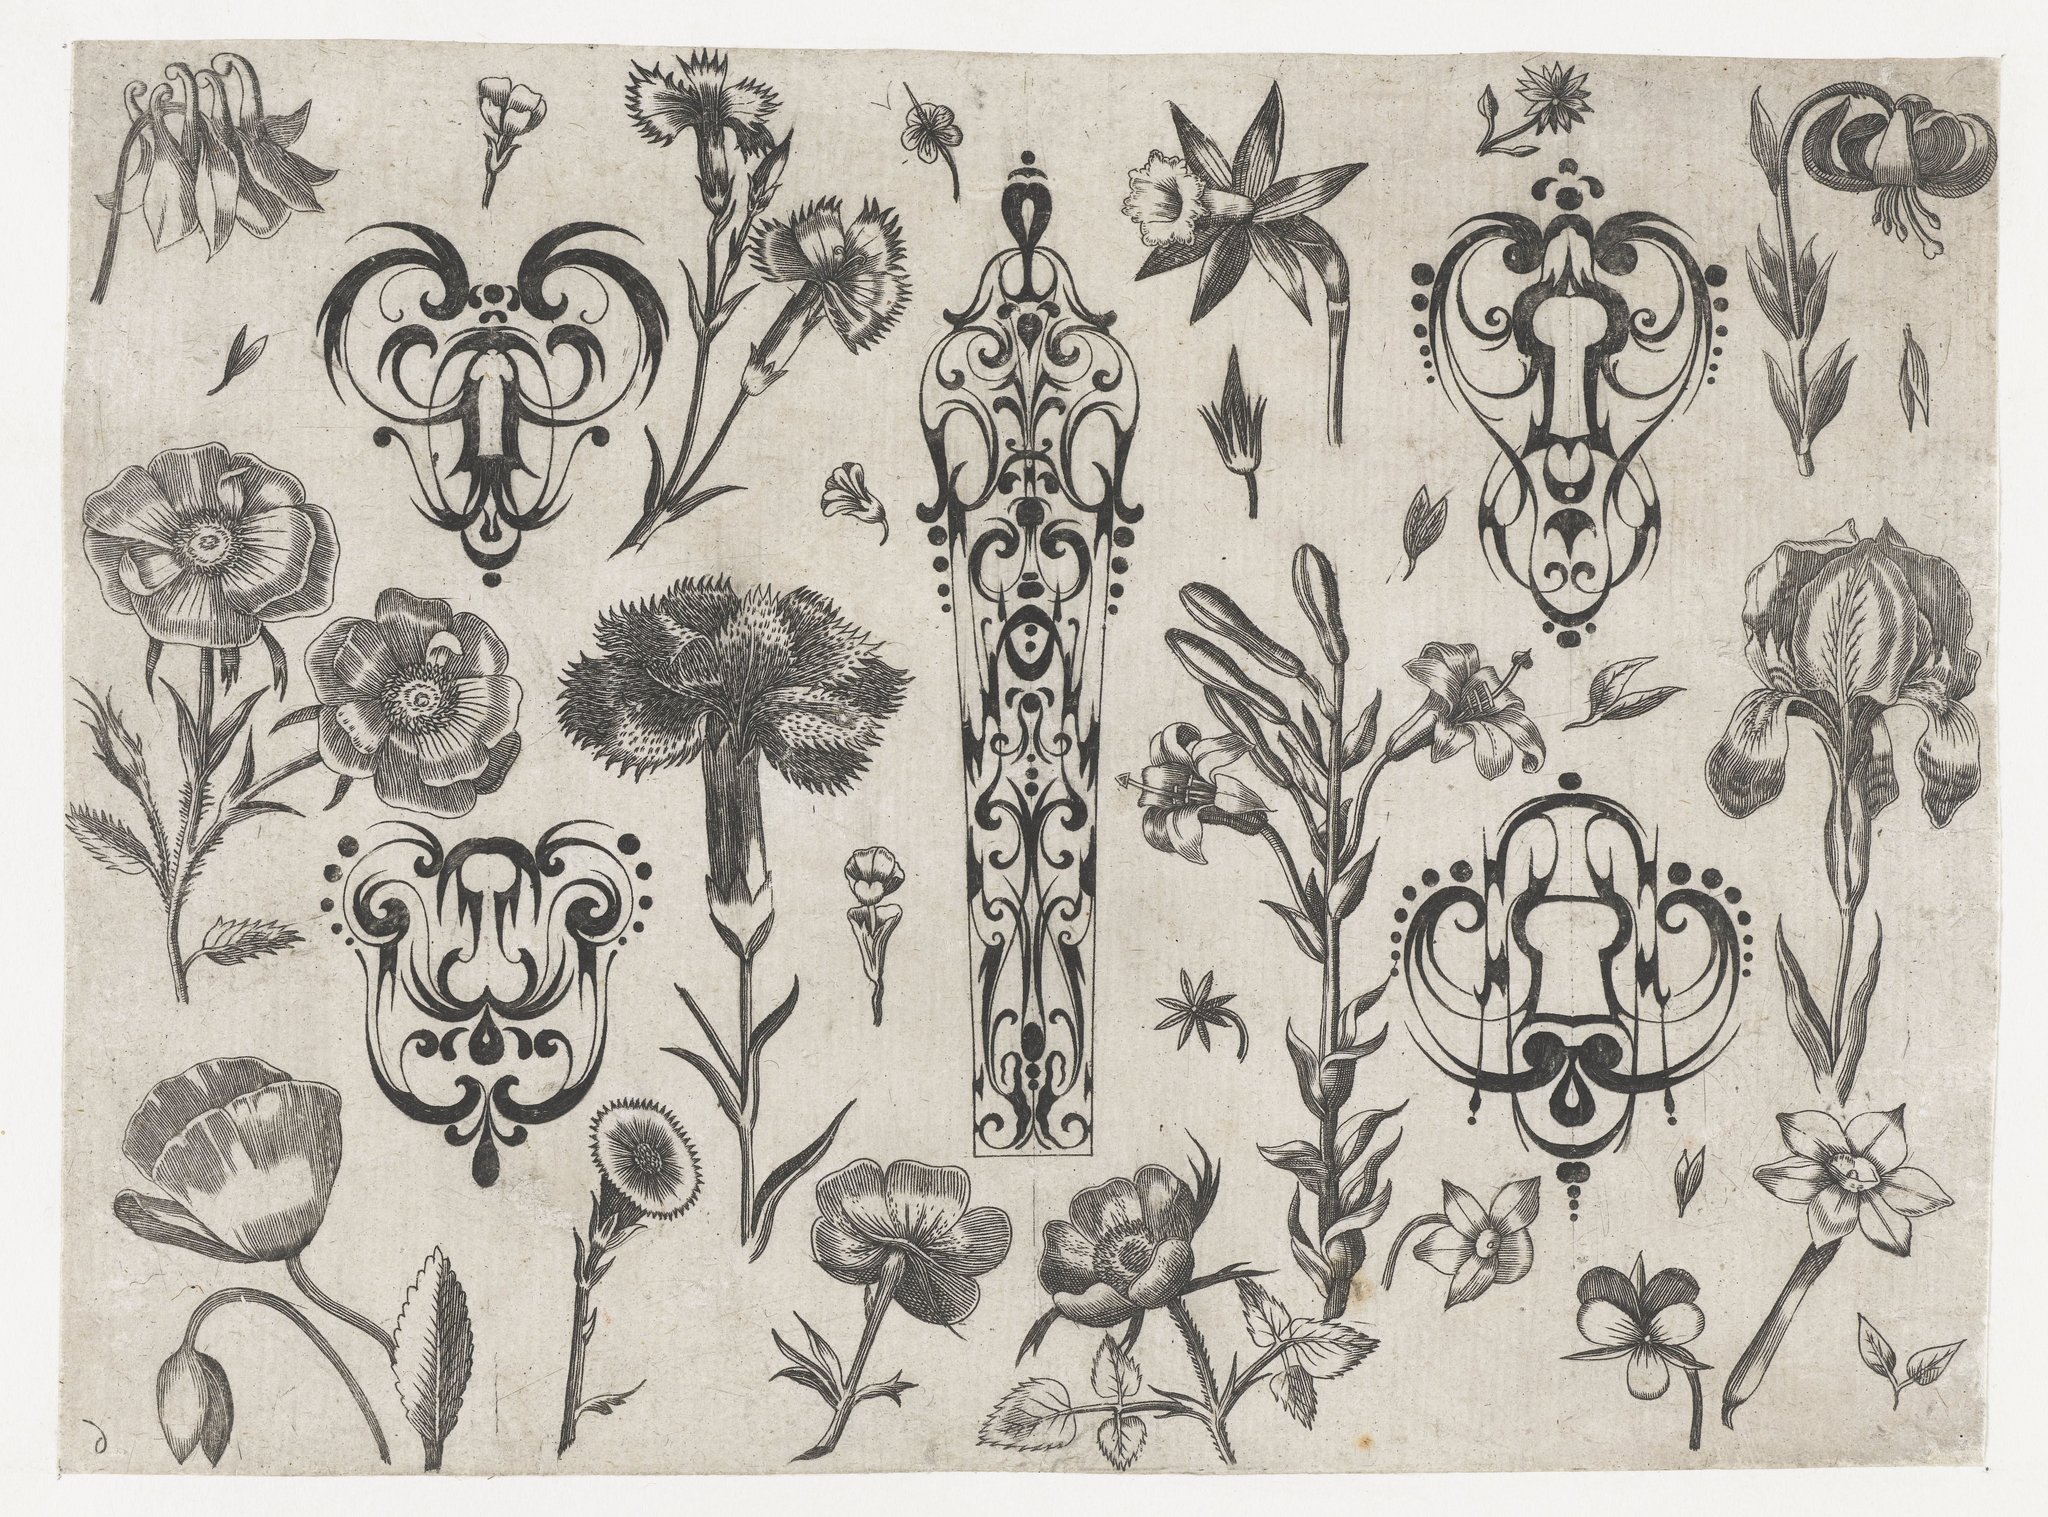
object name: ornament print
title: Zwartornamenten voor goud- en zilversmeden en emailleerders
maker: meynert jelissen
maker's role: print maker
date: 1622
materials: paper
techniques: engraving, etching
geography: groningen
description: Eén langwerpig Schweifwerk ornament in het midden, daaromheen vier kleinere.